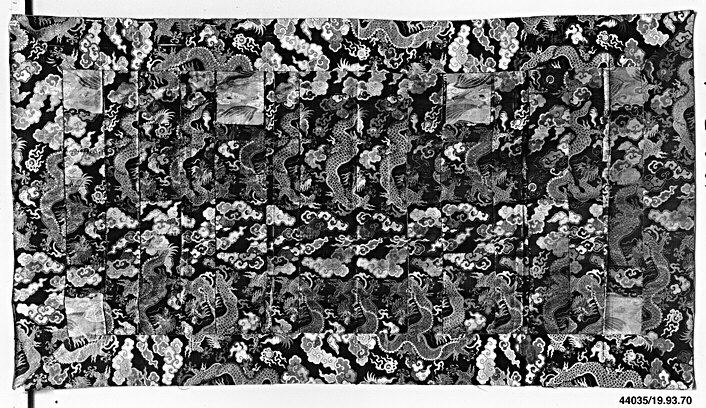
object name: robe, priest's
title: Priest's Robe (Shichijō)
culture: japanese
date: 1716-1736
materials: metal thread, silk